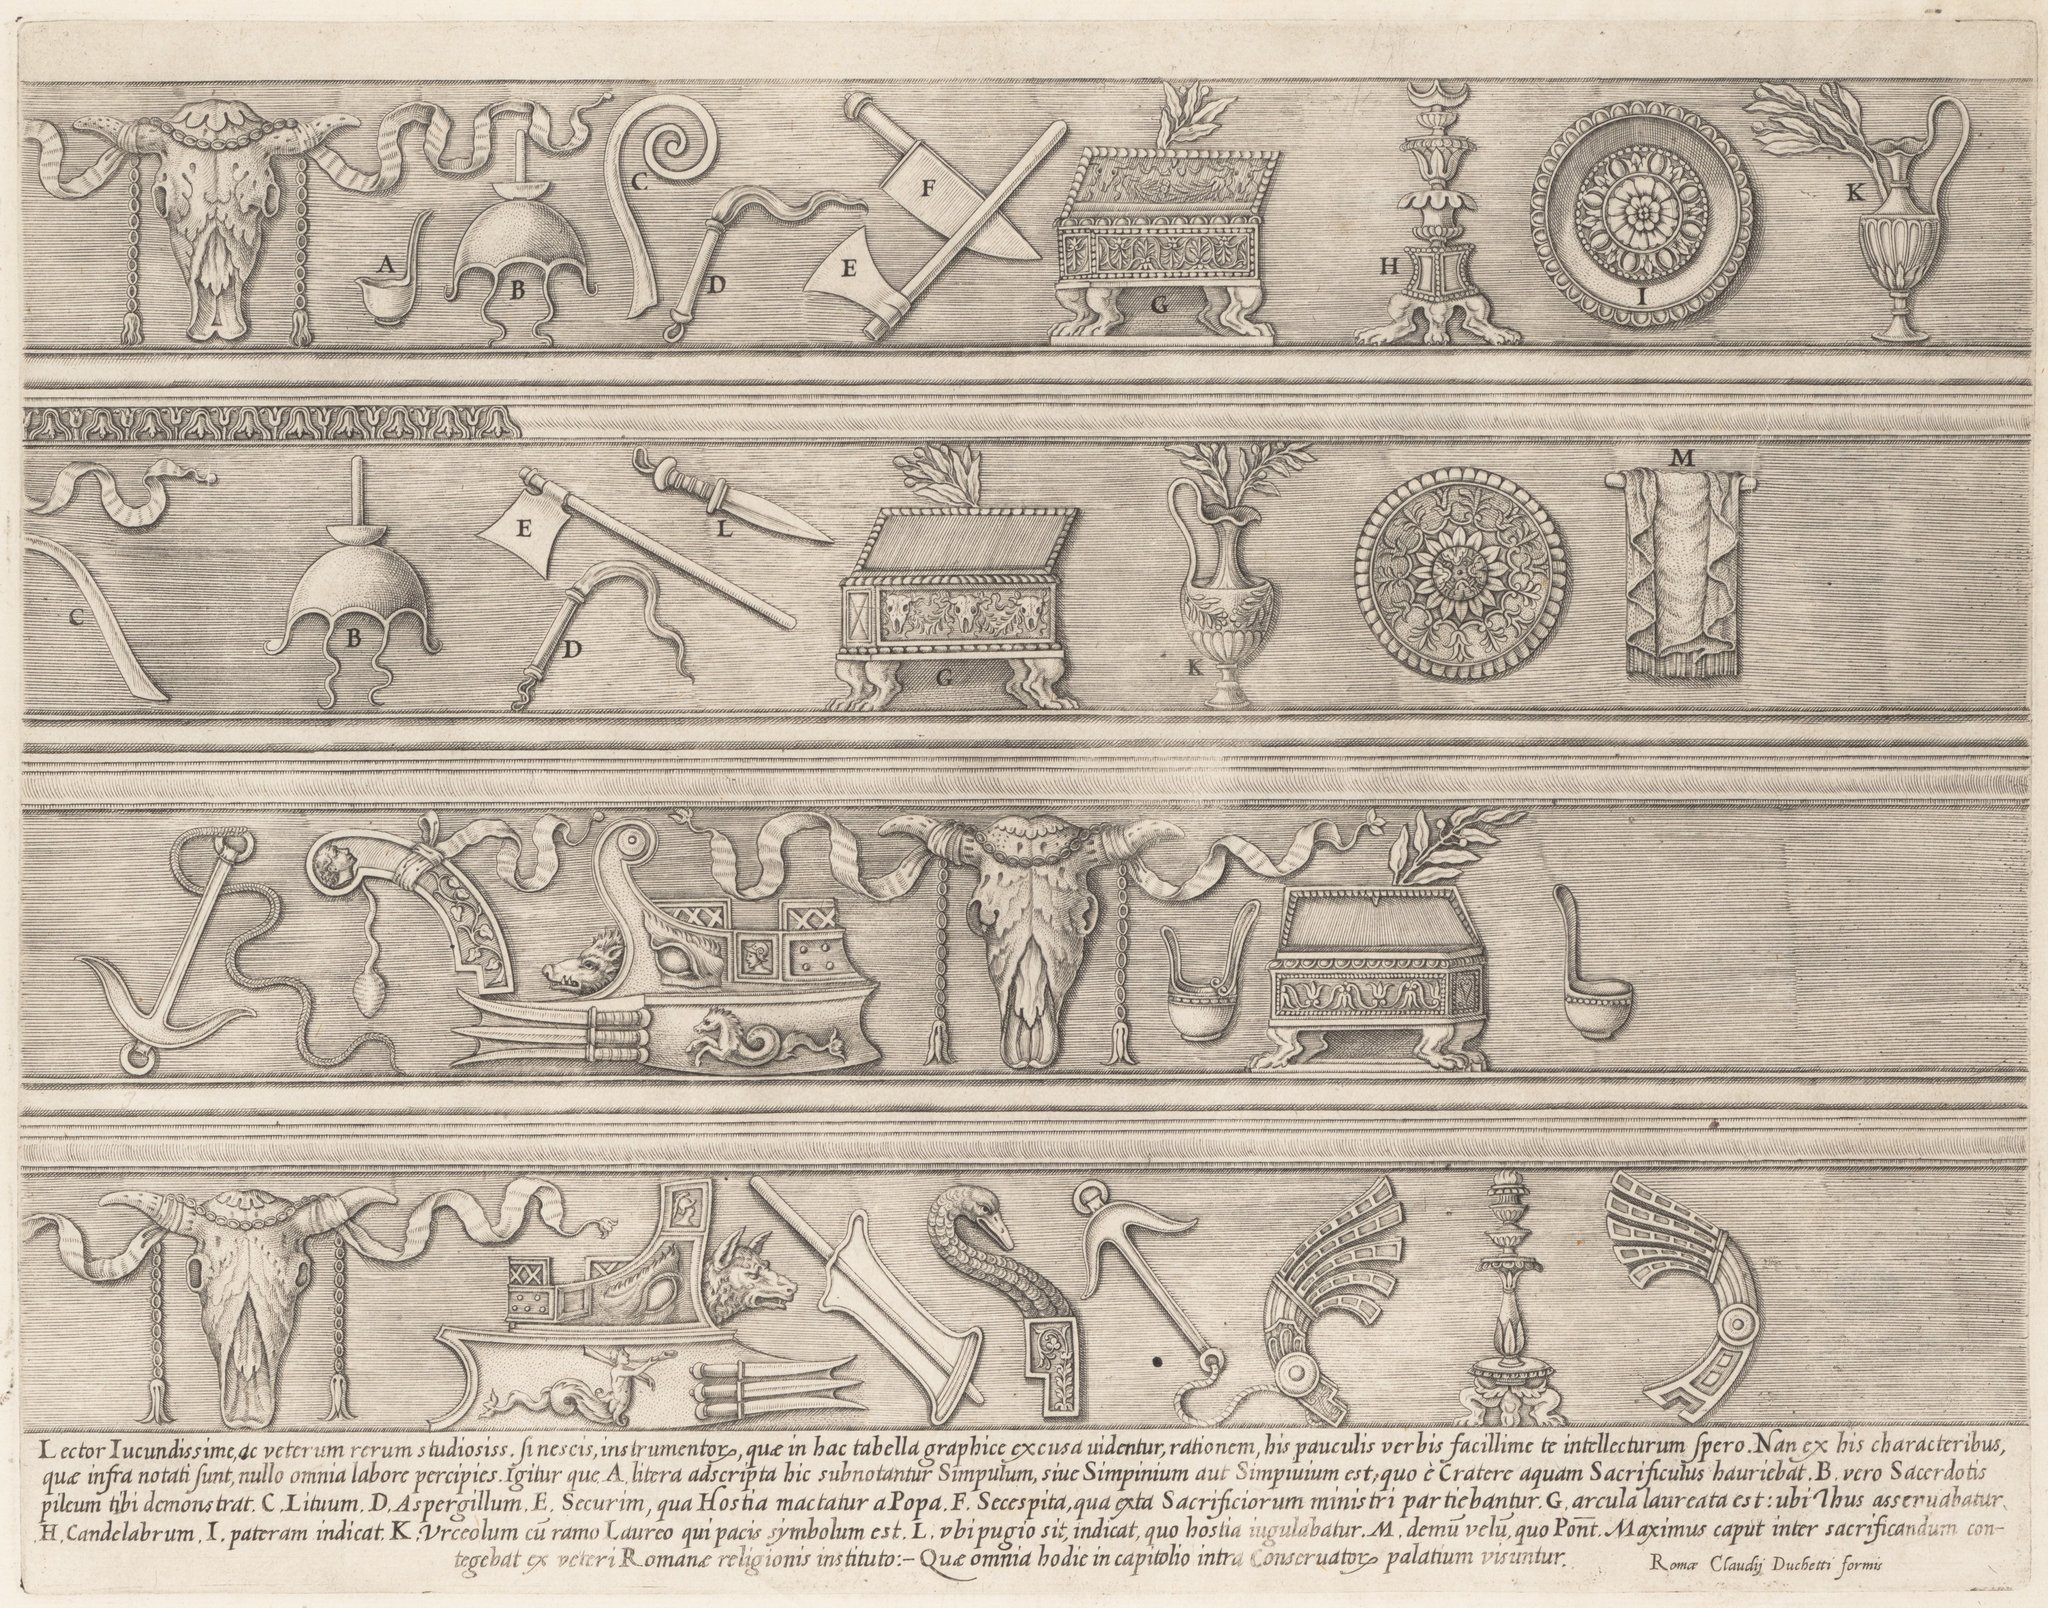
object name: print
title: Sacrificial Instruments Based on Ancient Relief Sculpture, from "Speculum Romanae Magnificentiae"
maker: nicolas beatrizet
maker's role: artist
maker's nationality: french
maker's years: 1515-1566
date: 1550-1575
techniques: engraving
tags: knives,skulls,axes